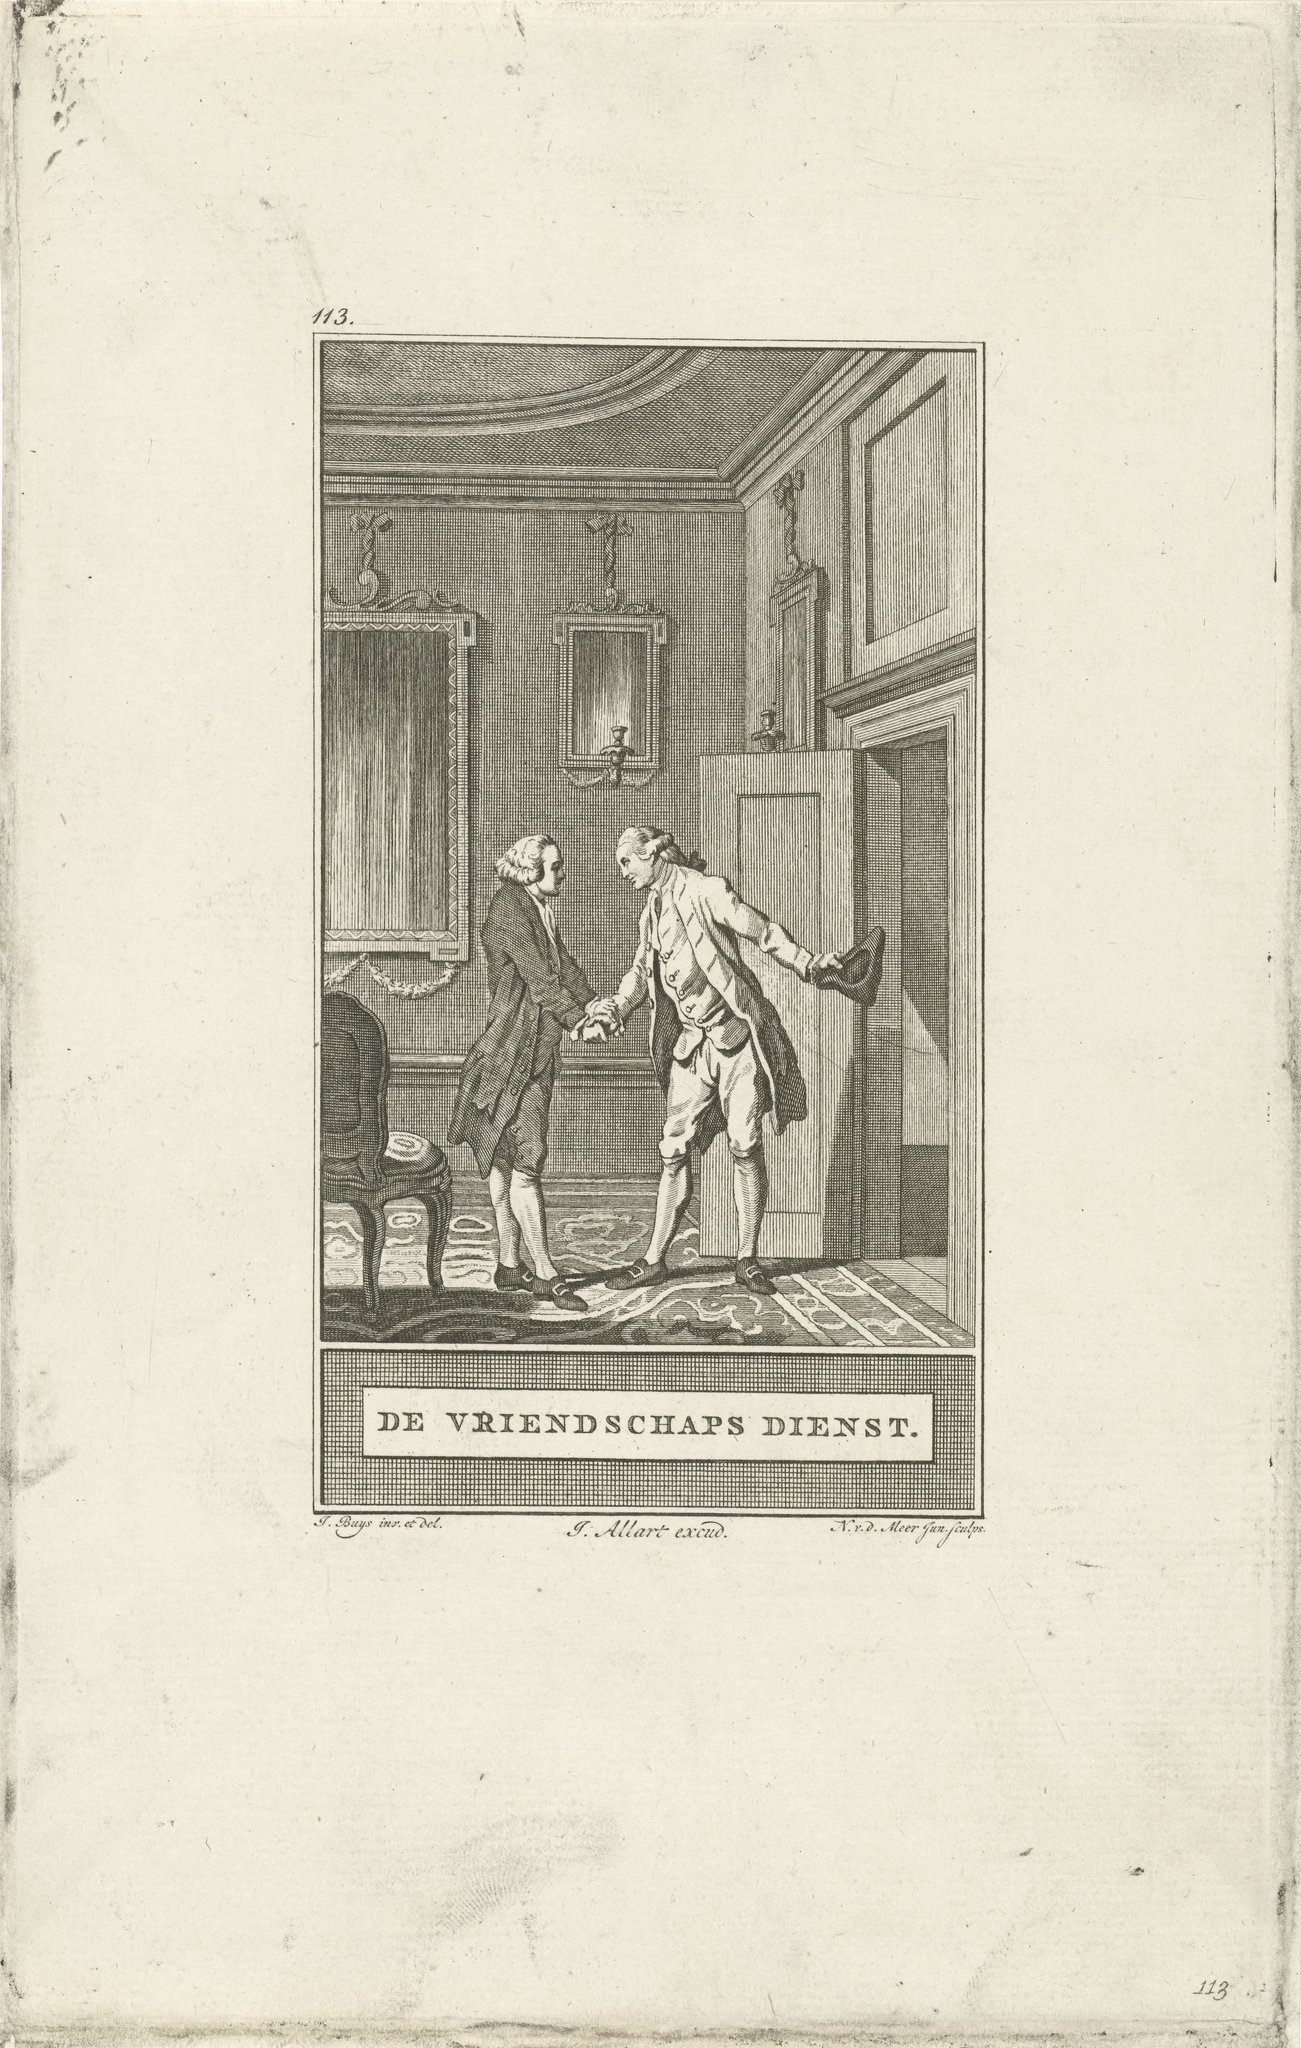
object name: print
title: Begroeting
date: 1778-1785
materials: paper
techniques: etching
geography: amsterdam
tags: open door, friends, gripping someone by the hand or the wrist; clasped hands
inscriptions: collector's mark: Lugt 2228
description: Prent bij: Gellert, Christian Fürchtegott. Fabelen en vertelsels. 3 dln. Amsterdam: Pieter Meyer, 1772-1774. De prenten bij deze publicatie werden later uitgegeven. De exemplaren uitgegeven door de weduwe Jacobus Loveringh & Johannes Allart tussen 1777 en 1778, de exemplaren uitgegeven door alleen Johannes Allart tussen 1778 en 1785.